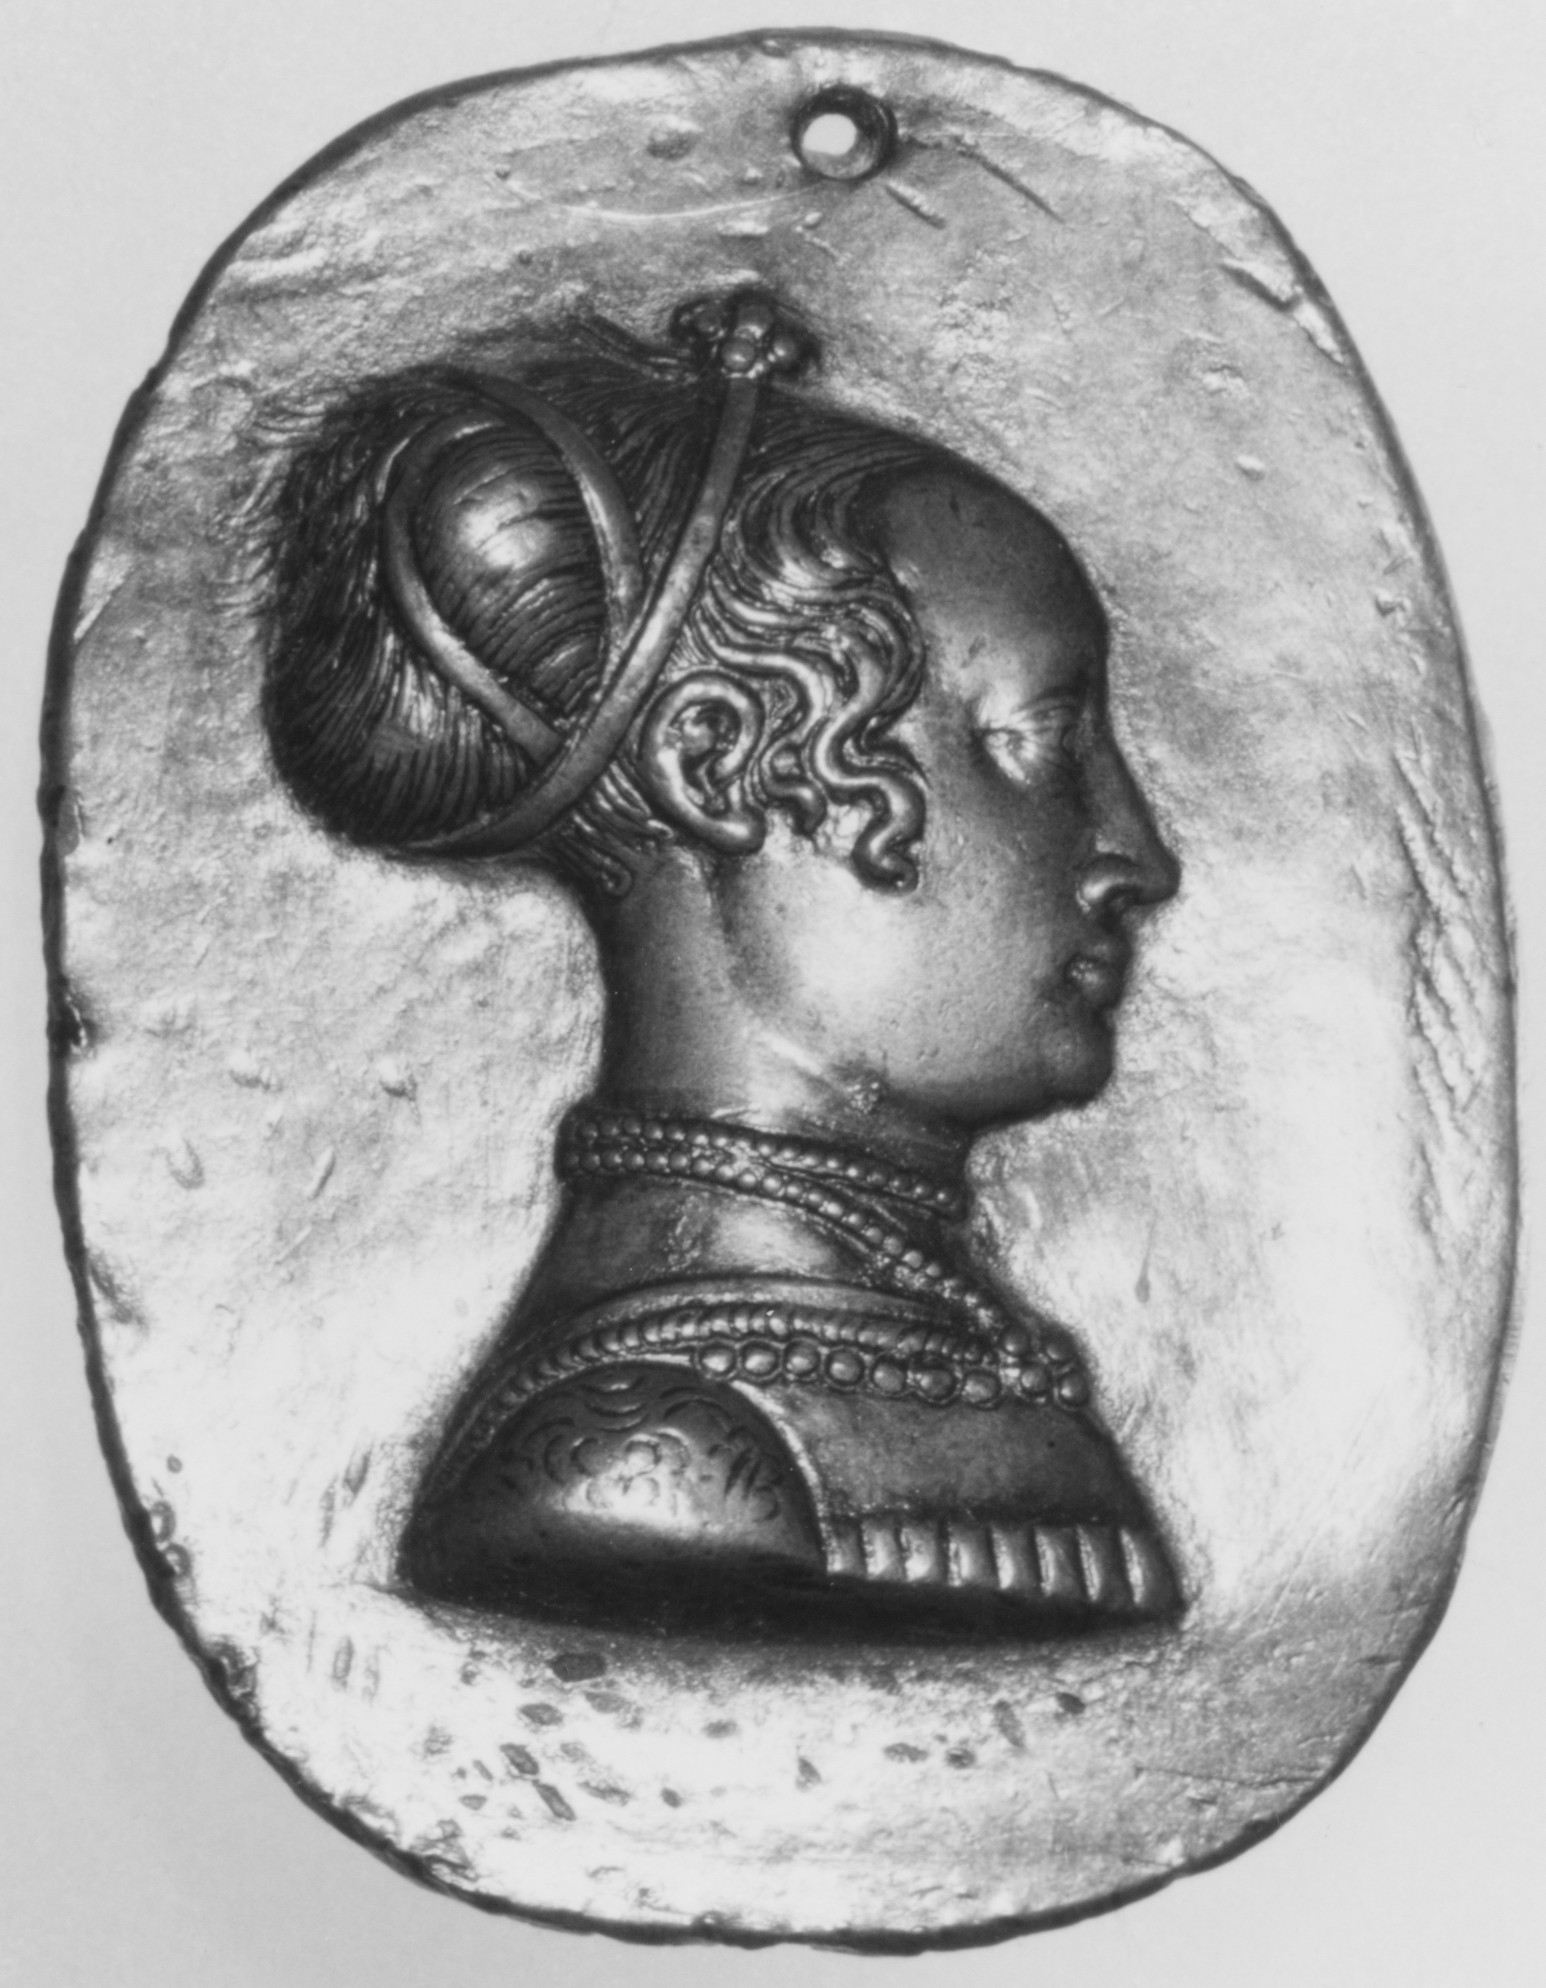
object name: medal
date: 1401-1500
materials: bronze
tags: profiles,women